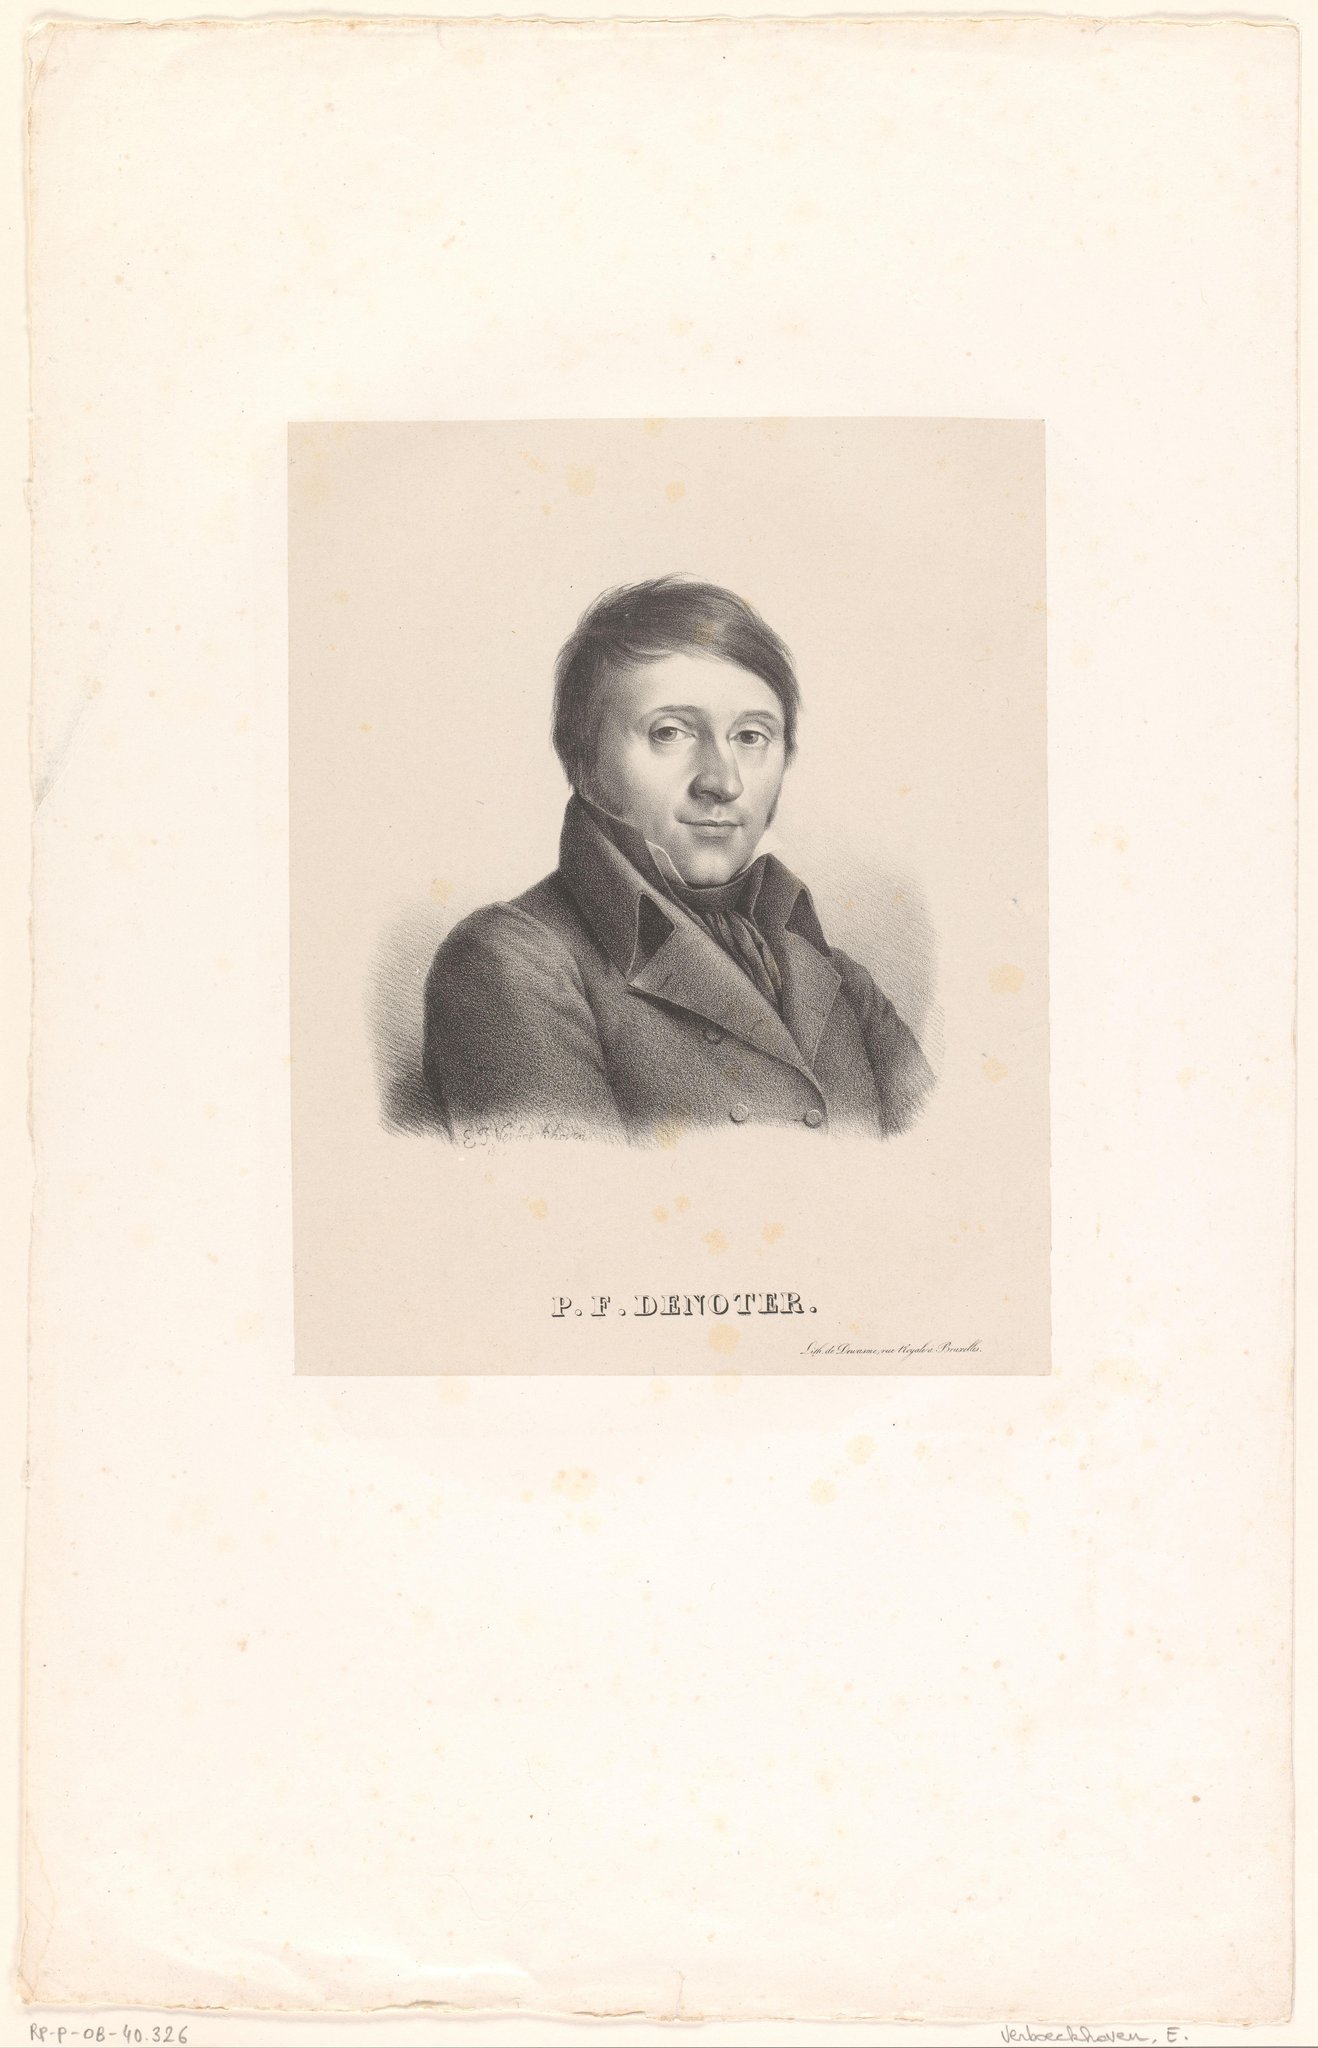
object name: print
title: Portret van Pierre François De Noter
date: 1825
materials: paper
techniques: lithograph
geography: brussels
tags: ghent, painter, print maker, pierre françois de noter, historical persons, portrait, self-portrait of painter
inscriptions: date